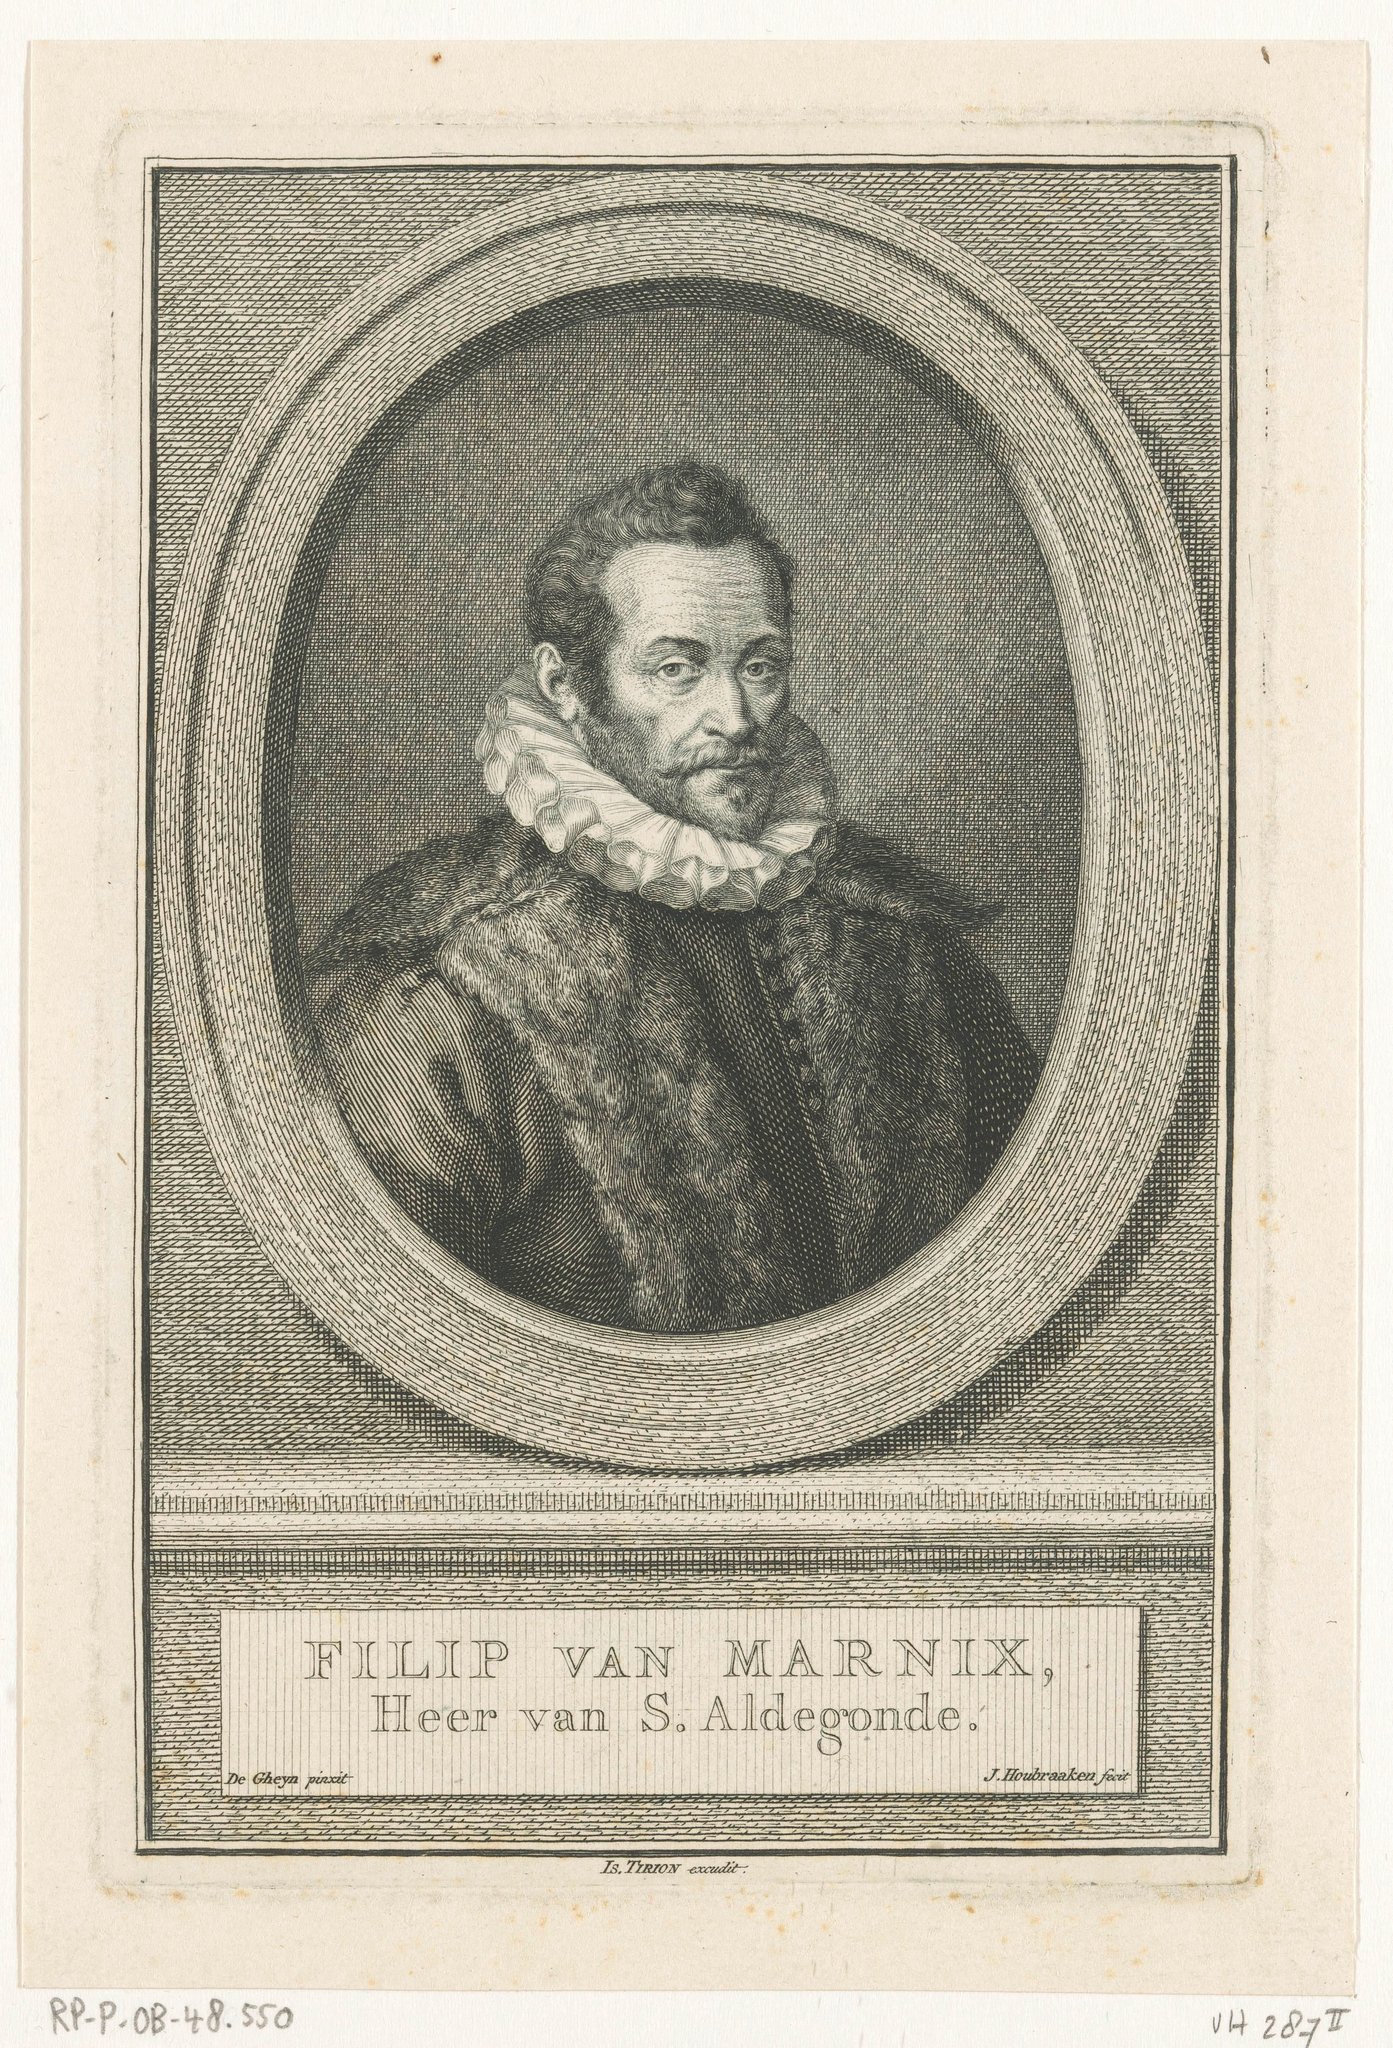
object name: print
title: Portret van Filips van Marnix, heer van Sint-Aldegonde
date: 1749-1759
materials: paper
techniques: engraving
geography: amsterdam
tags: brussels, politician, filips van marnix van sint-aldegonde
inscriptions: collector's mark: Lugt 240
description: Prent ook gebruikt in: Jan Wagenaar, Vaderlandsche historie, vervattende de geschiedenissen der nu Vereenigde Nederlanden, inzonderheid die van Holland (...), 21 delen. Amsterdam, Isaak Tirion, 1749-59.